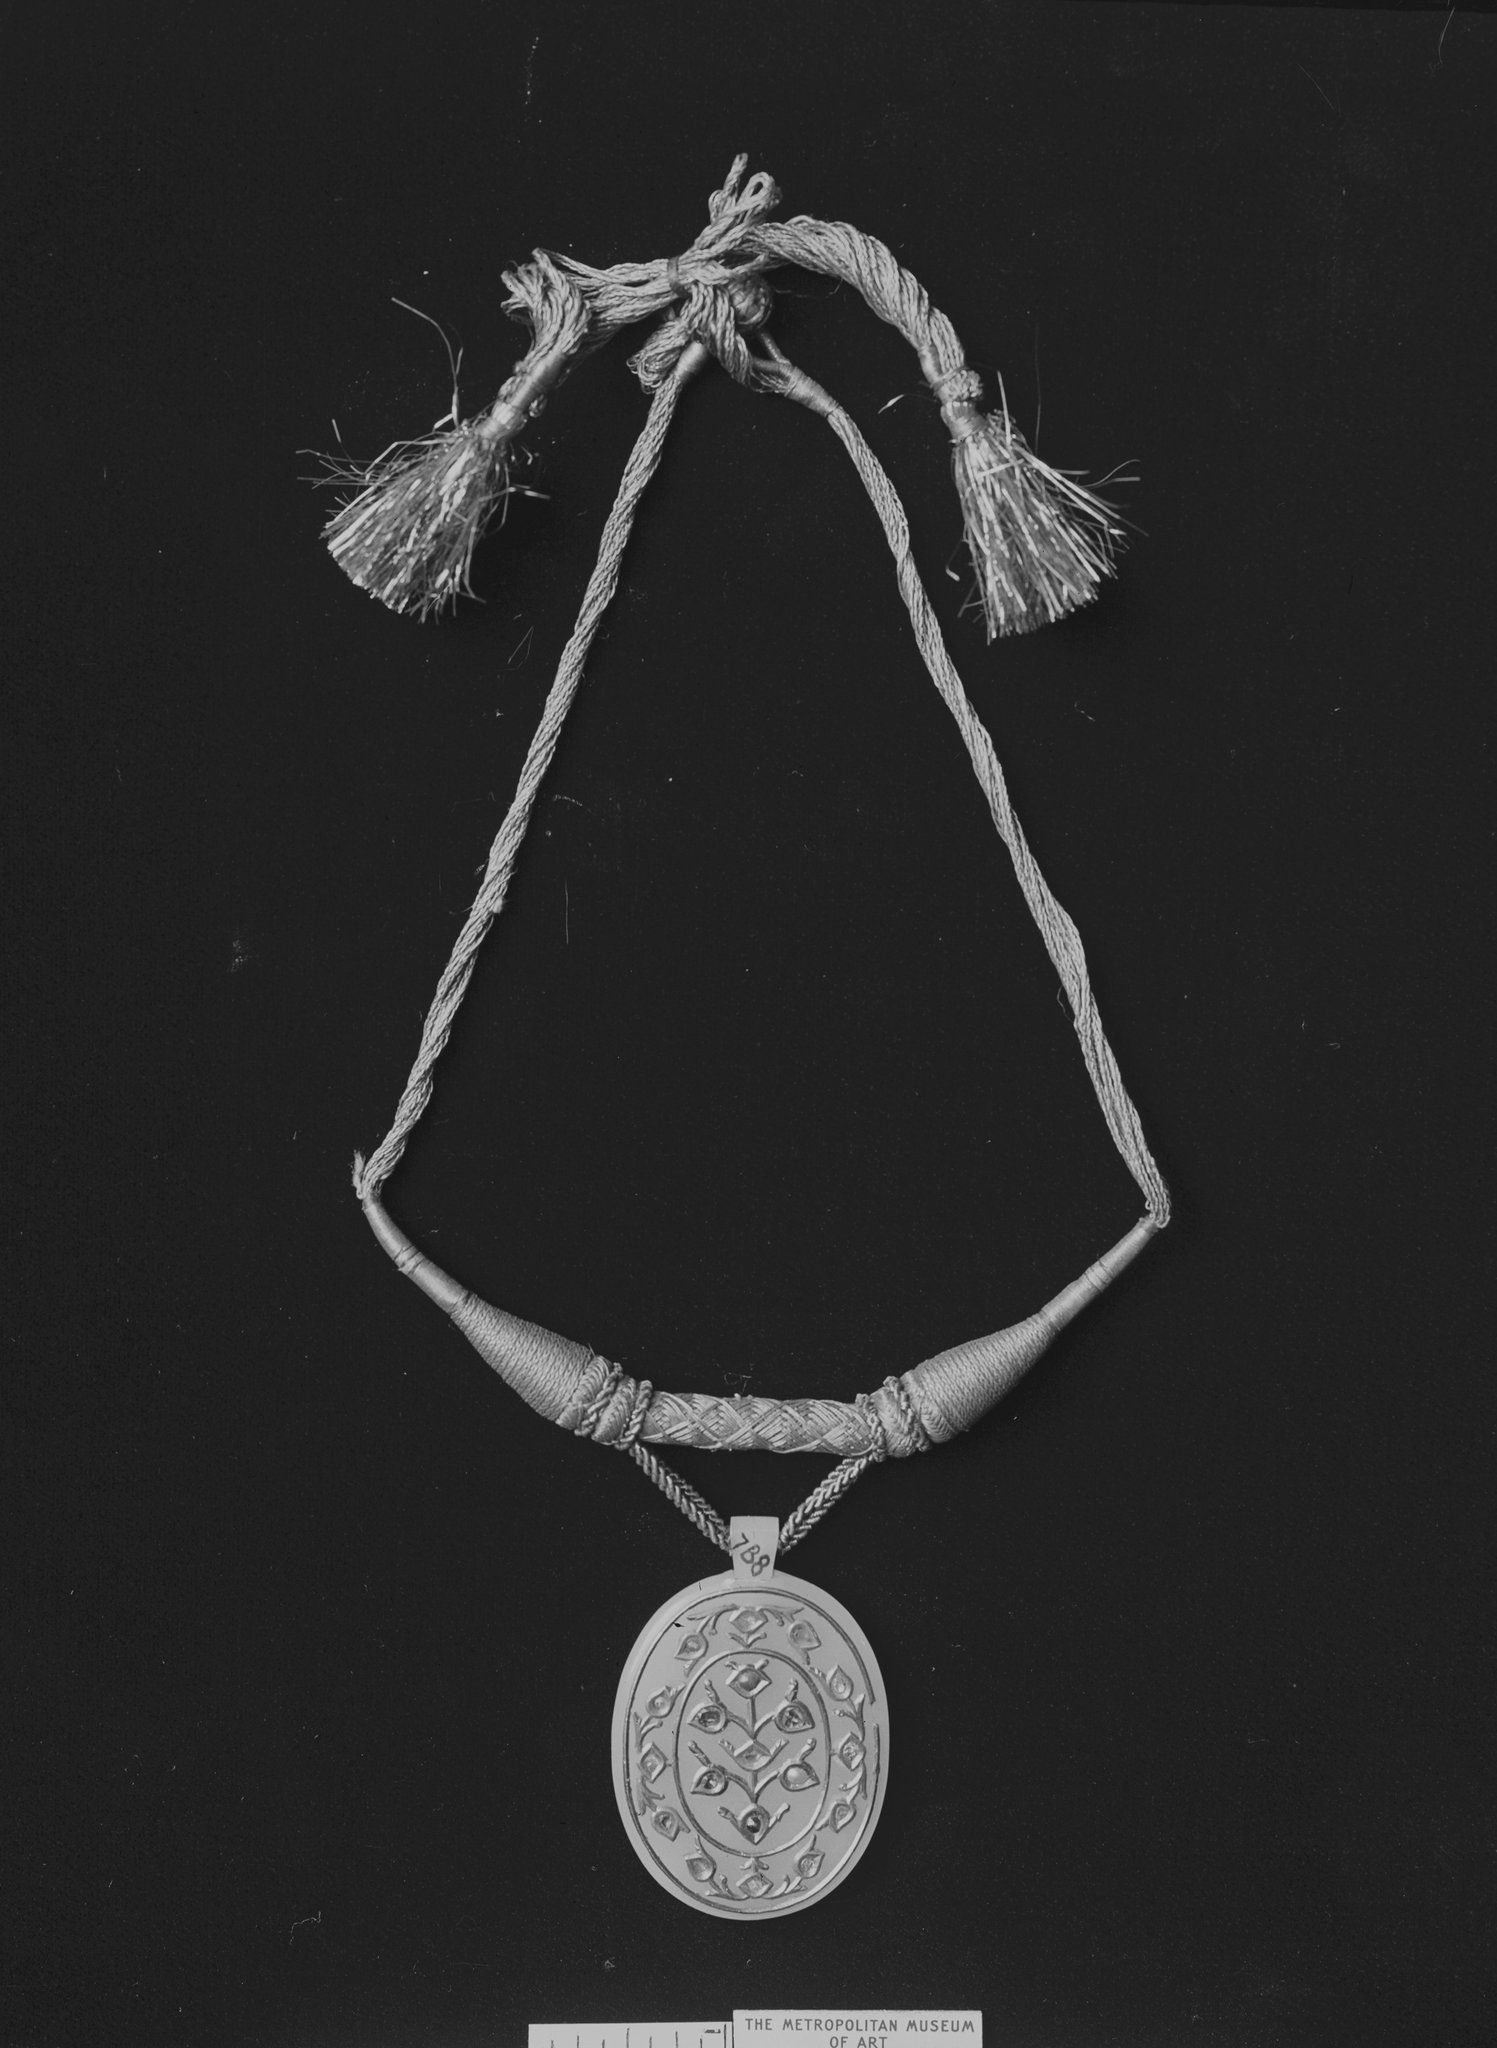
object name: pendant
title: Jewelled Pendant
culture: indian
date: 1801-1900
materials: jade